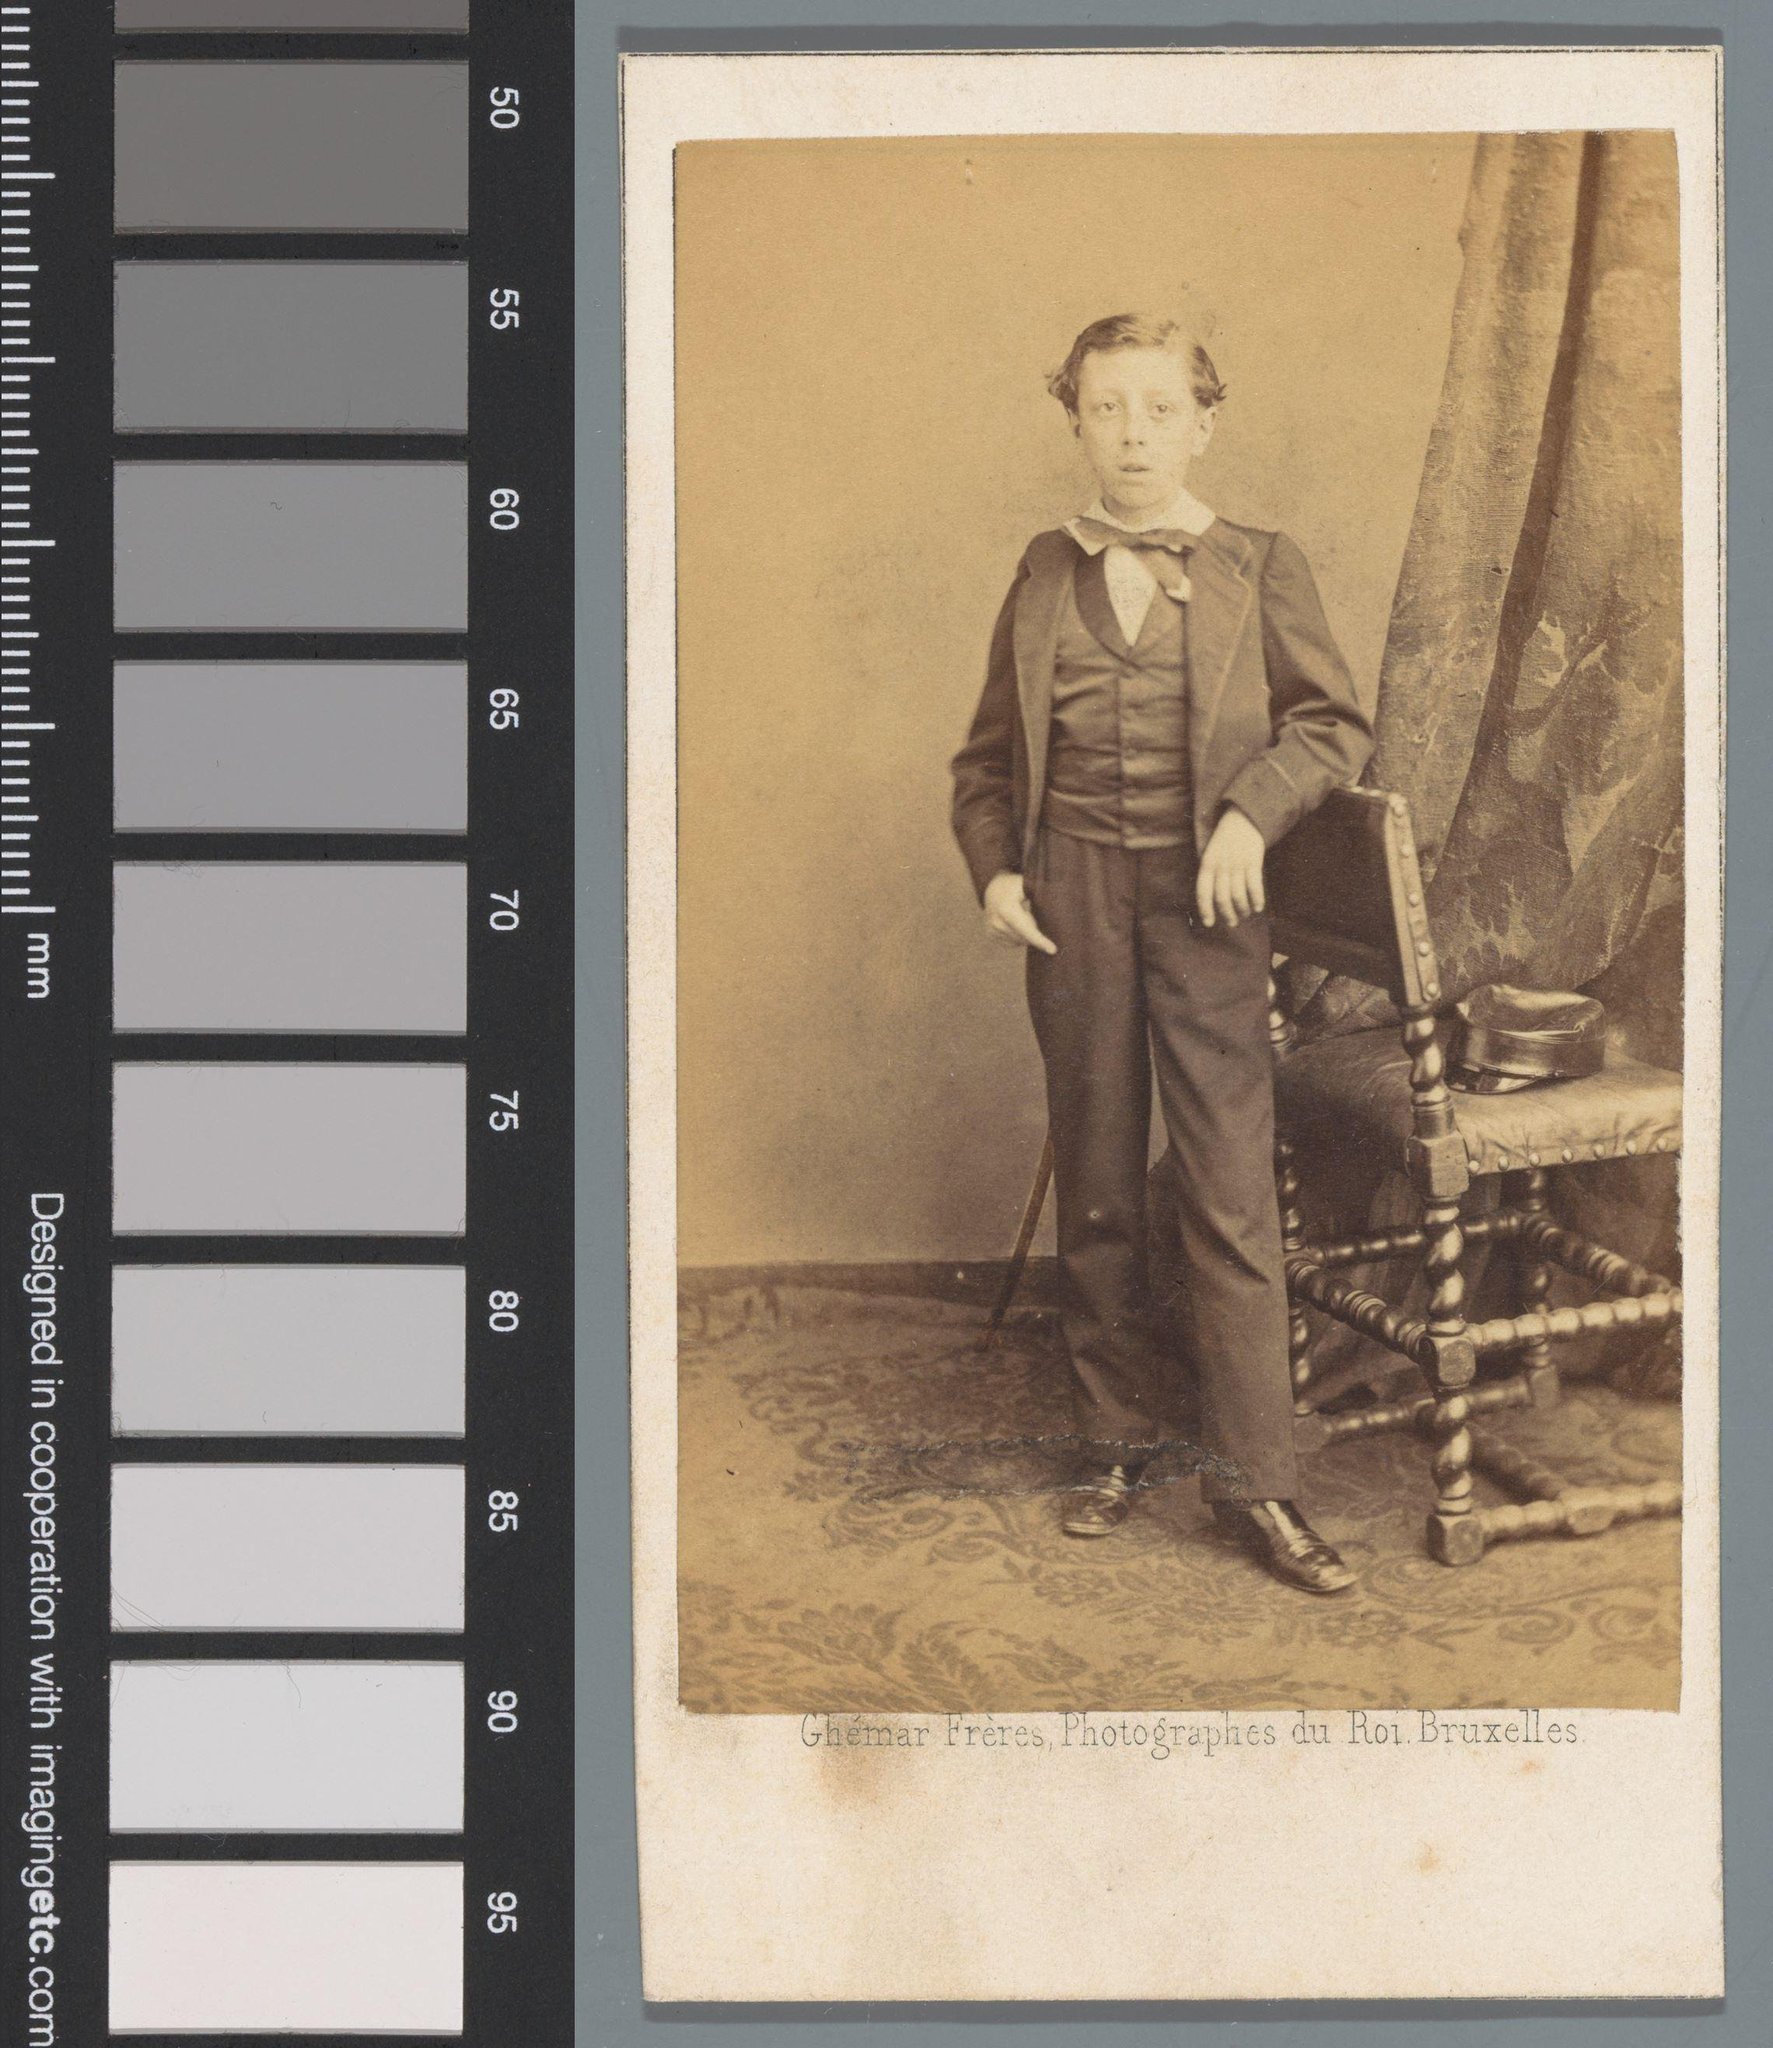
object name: carte de visite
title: Portret van een onbekende jongen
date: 1859-1890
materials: cardboard, paper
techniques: albumen print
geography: brussels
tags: boy (child between toddler and youth), anonymous historical person portrayed, brussels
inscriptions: inscription: ‘Atelier de photographie./ Ghémar Frères,/ photographes du Roi,/ 27, rue de l'Ecuyer,/ entrée par la porte cochère./ Bruxelles’, inscription: ‘Ghémar Frères. Photographes du Roi. Bruxelles’